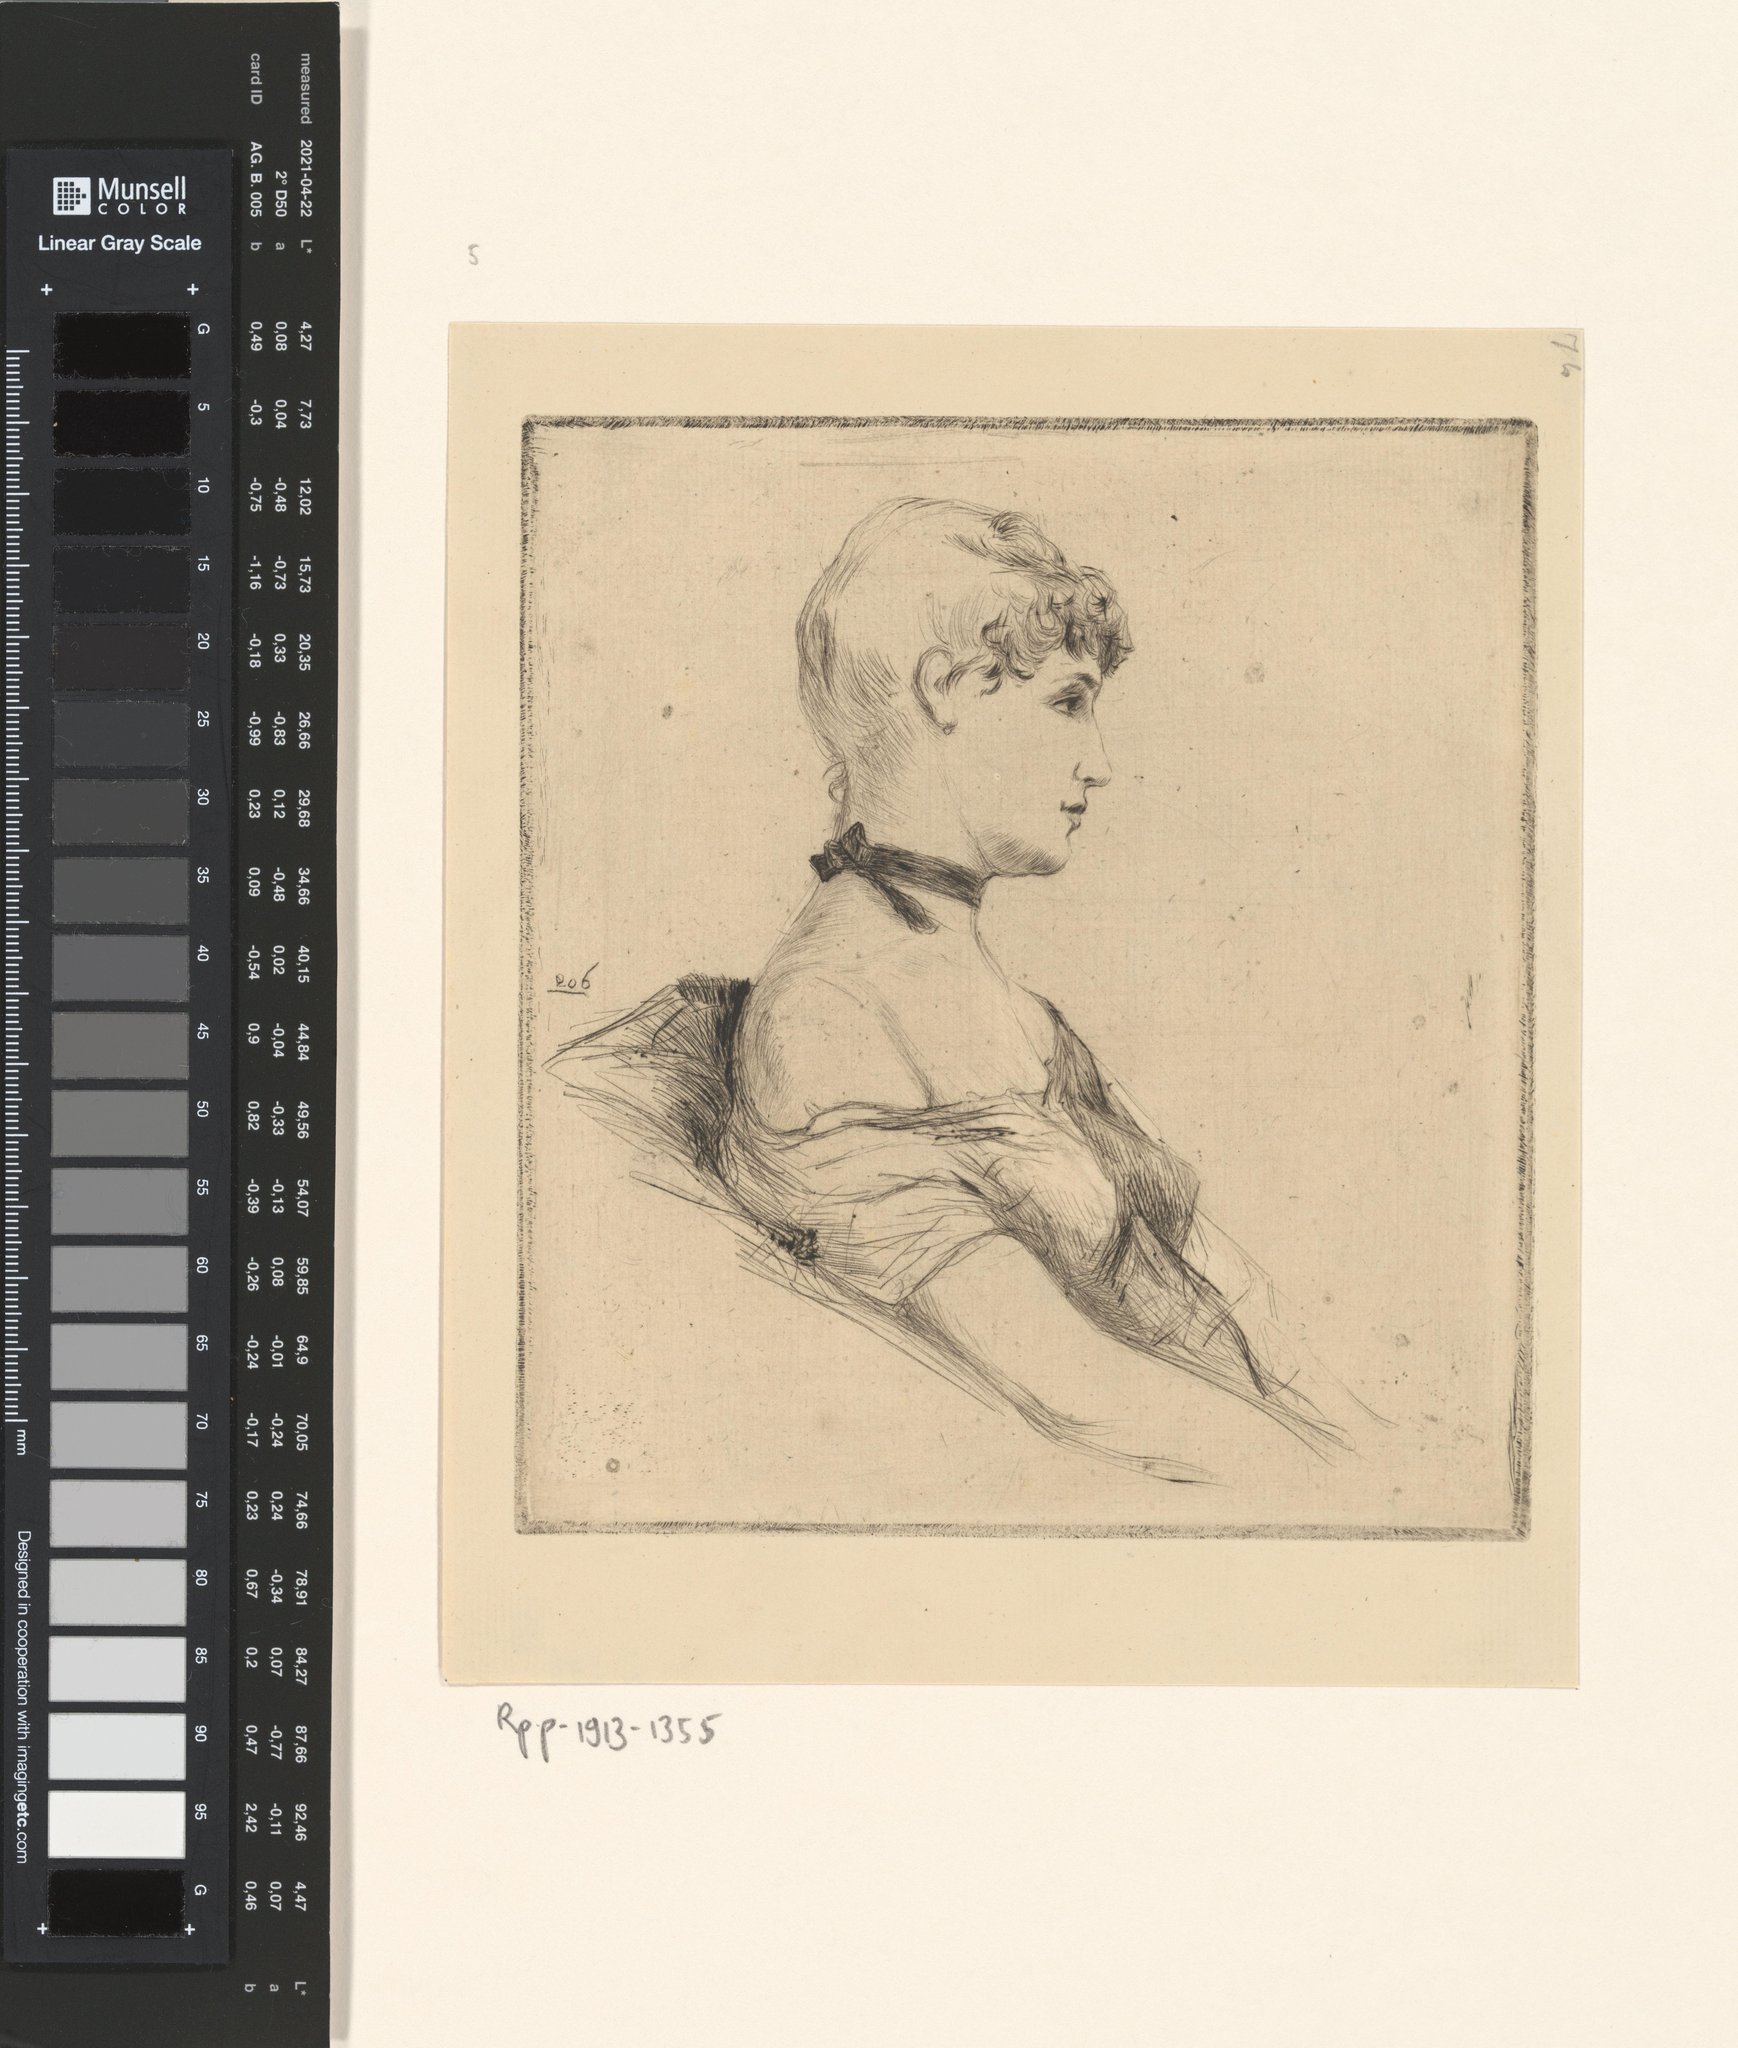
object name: print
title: Riki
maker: philip zilcken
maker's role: draughtsman, painter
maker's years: 1857-1930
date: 1890-1913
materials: paper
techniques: drypoint, intaglio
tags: adolescent, young woman, maiden, historical persons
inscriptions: collector's mark: Lugt 2233